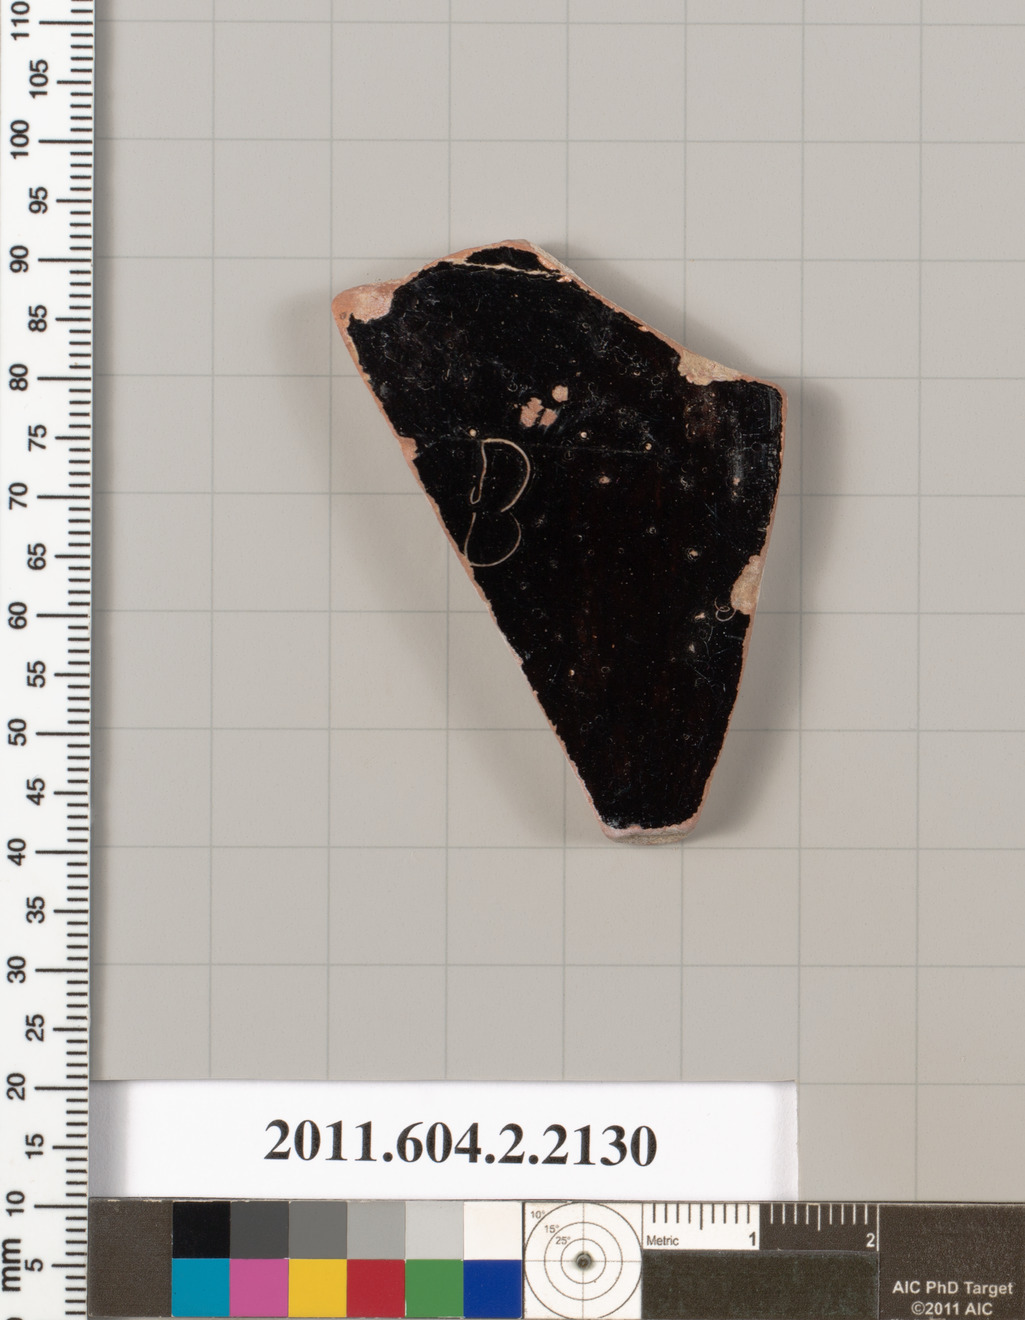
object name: pot fragment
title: Terracotta fragment of a pot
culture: greek, attic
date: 600-401 BCE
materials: terracotta